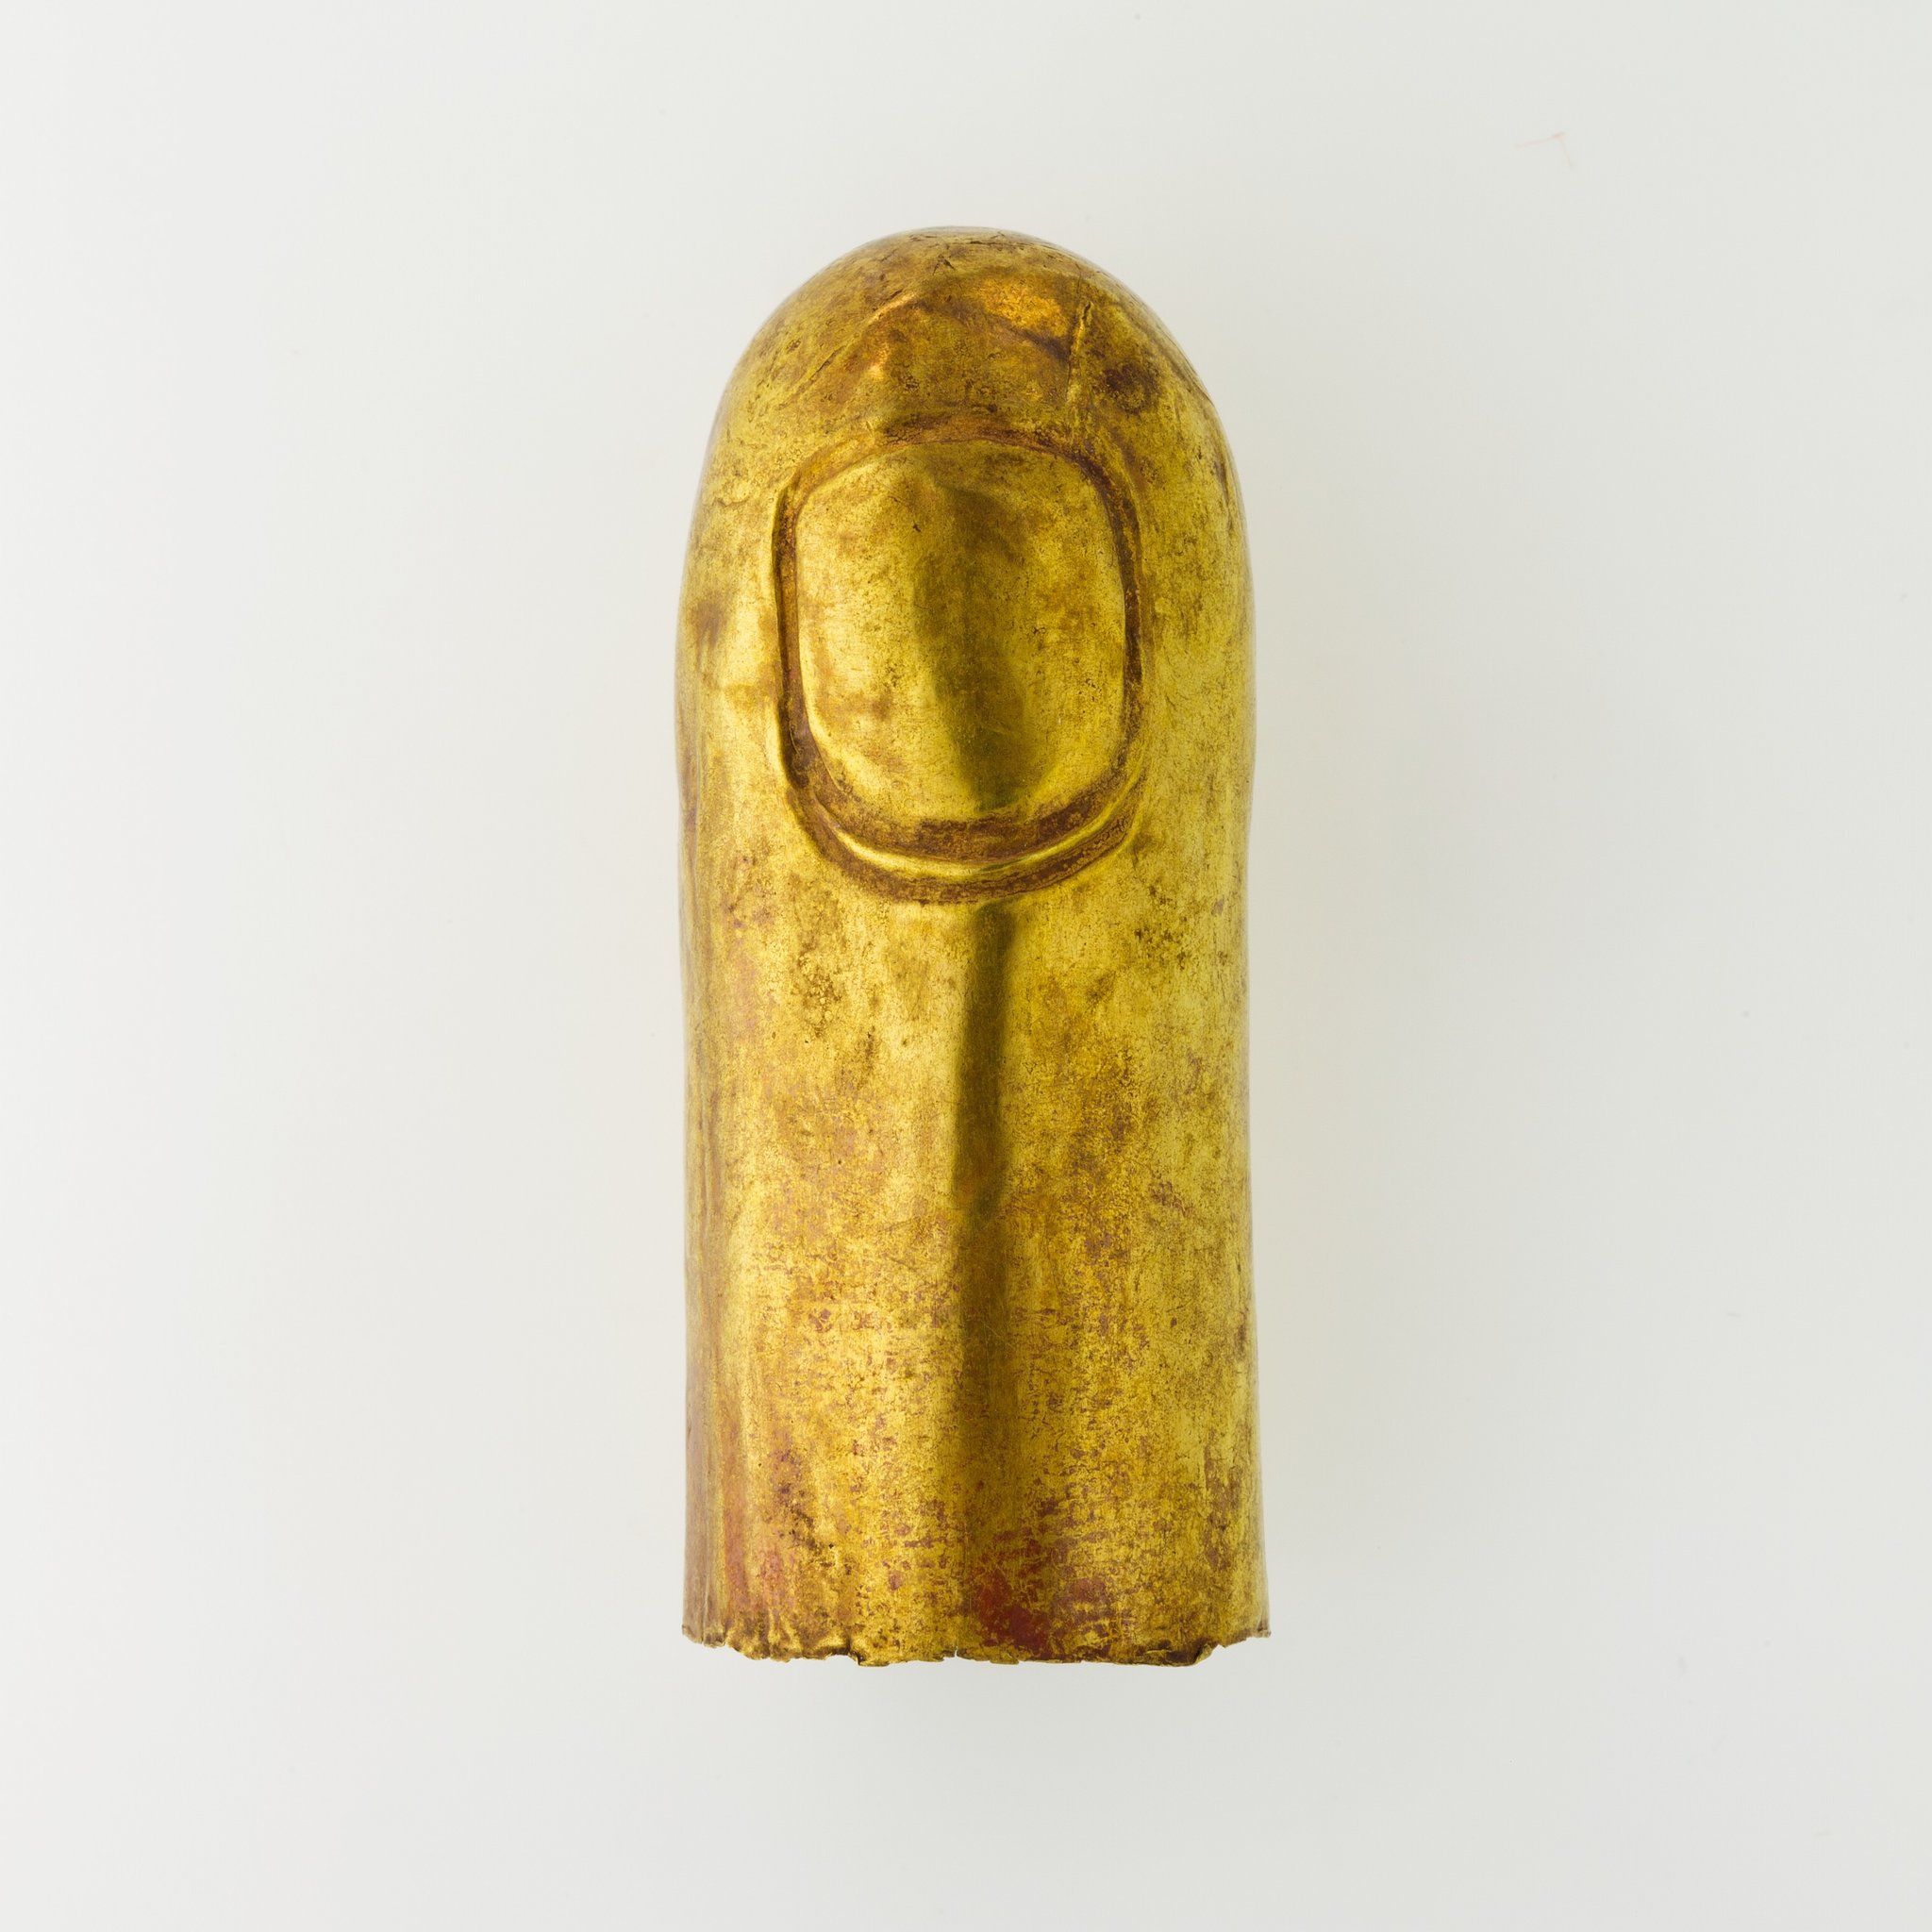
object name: finger stall, group 1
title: Finger stall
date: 1479-1425 BCE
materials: gold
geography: egypt